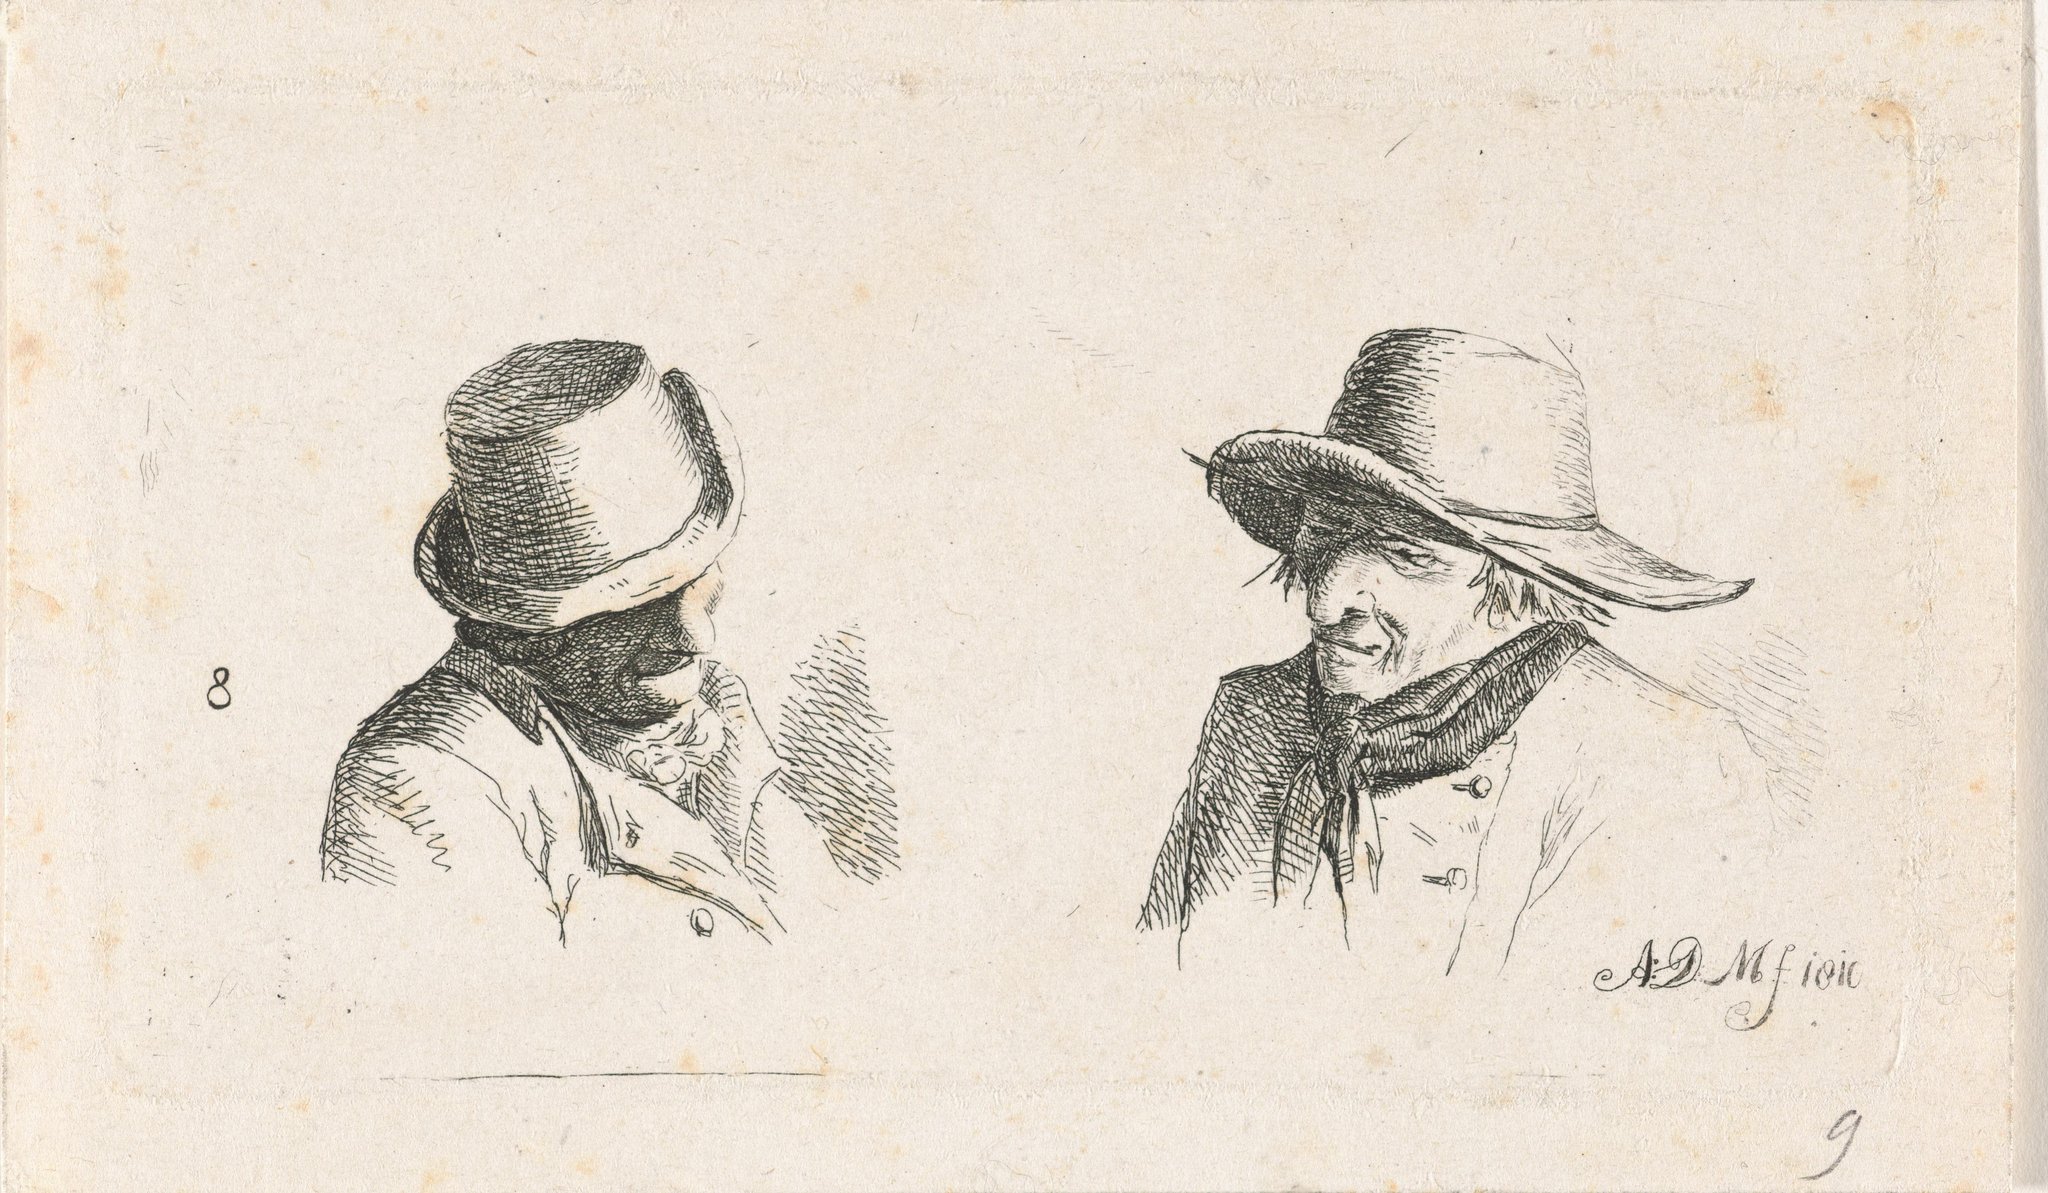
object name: print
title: Twee mannen met hoeden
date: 1810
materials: paper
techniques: etching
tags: head-gear: hat (+ men's clothes)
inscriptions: collector's mark: Lugt 2227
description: Twee bustes van een man met een hoed op.